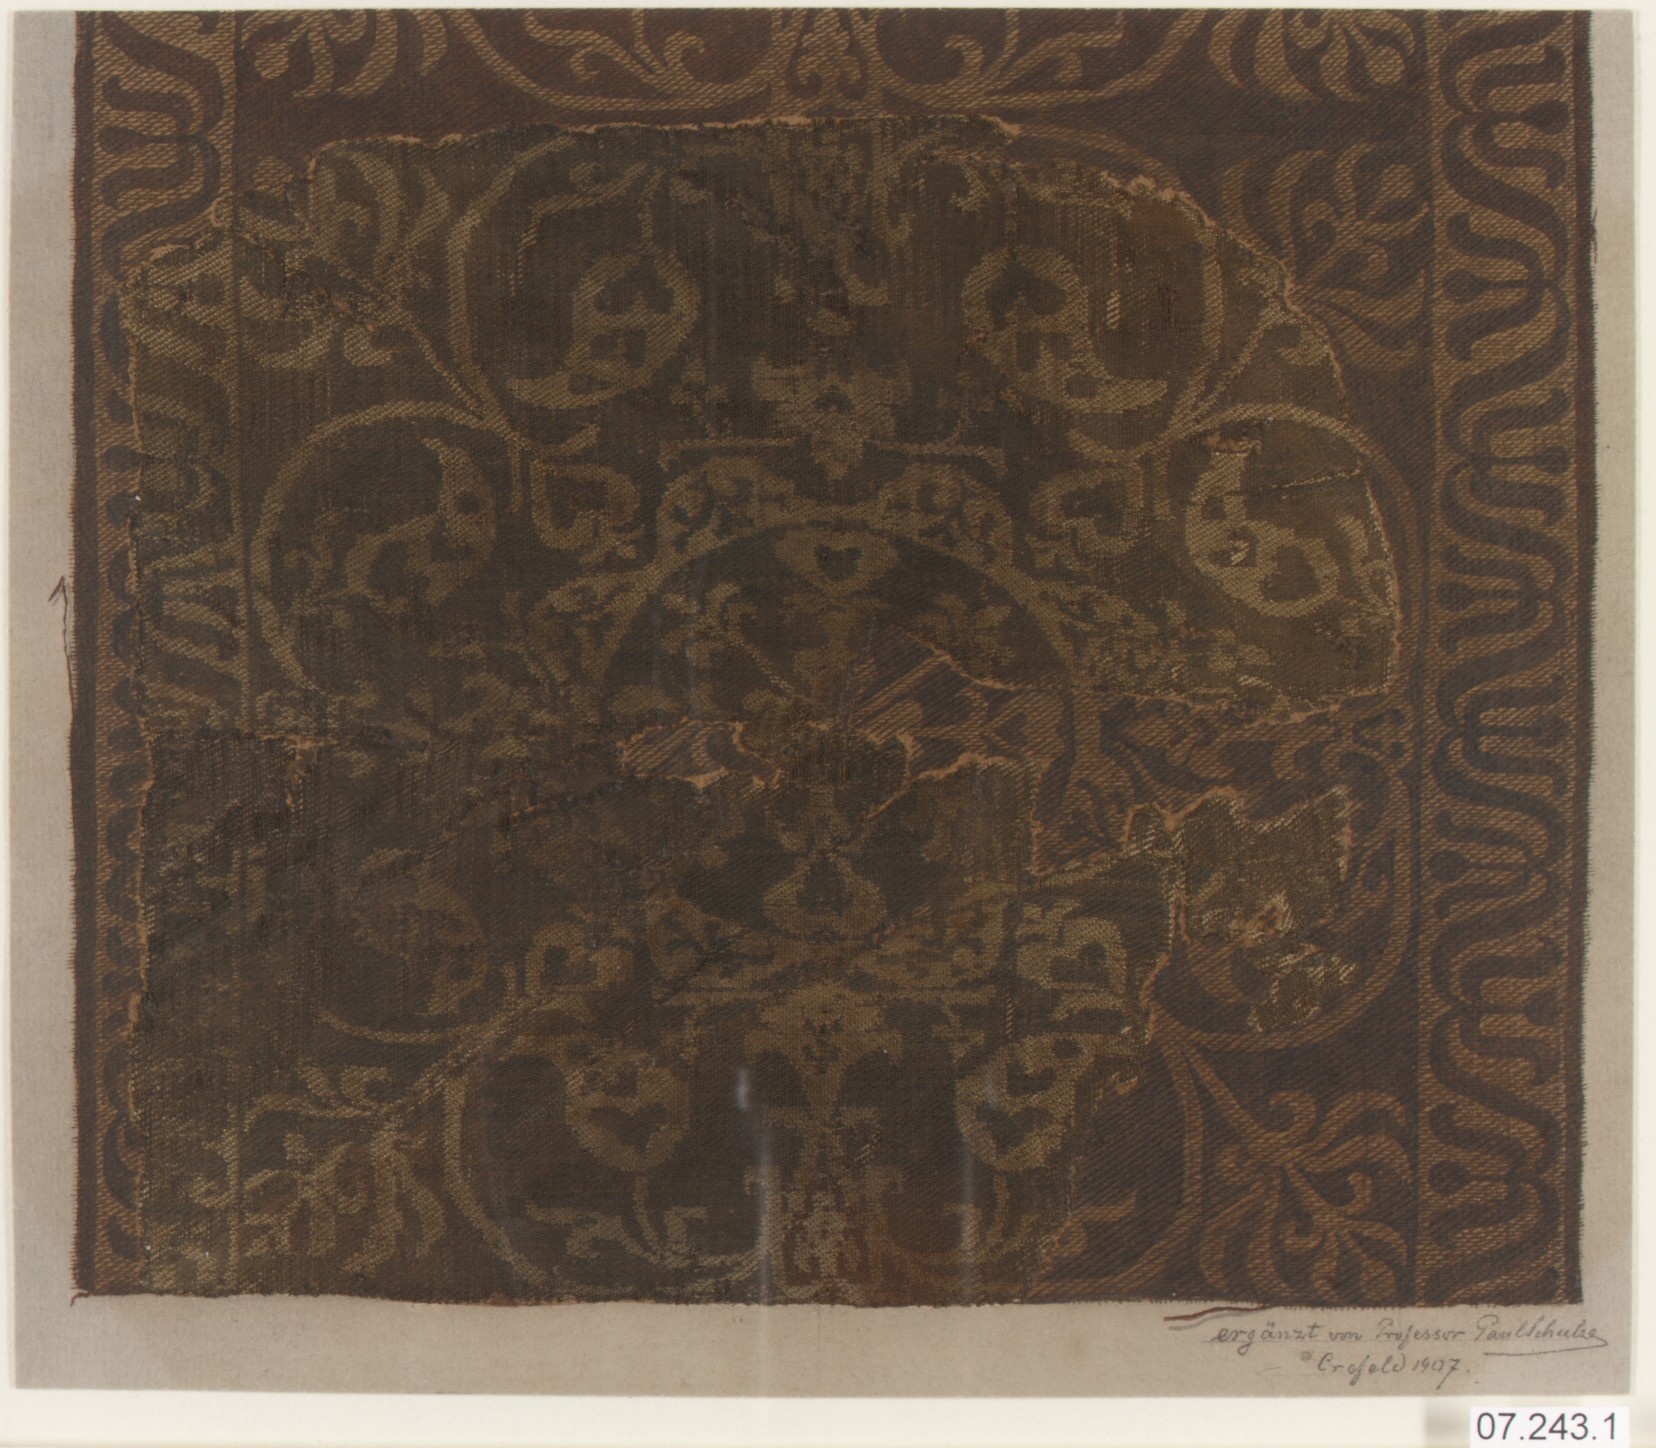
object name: textile fragment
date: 401-600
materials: silk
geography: iran